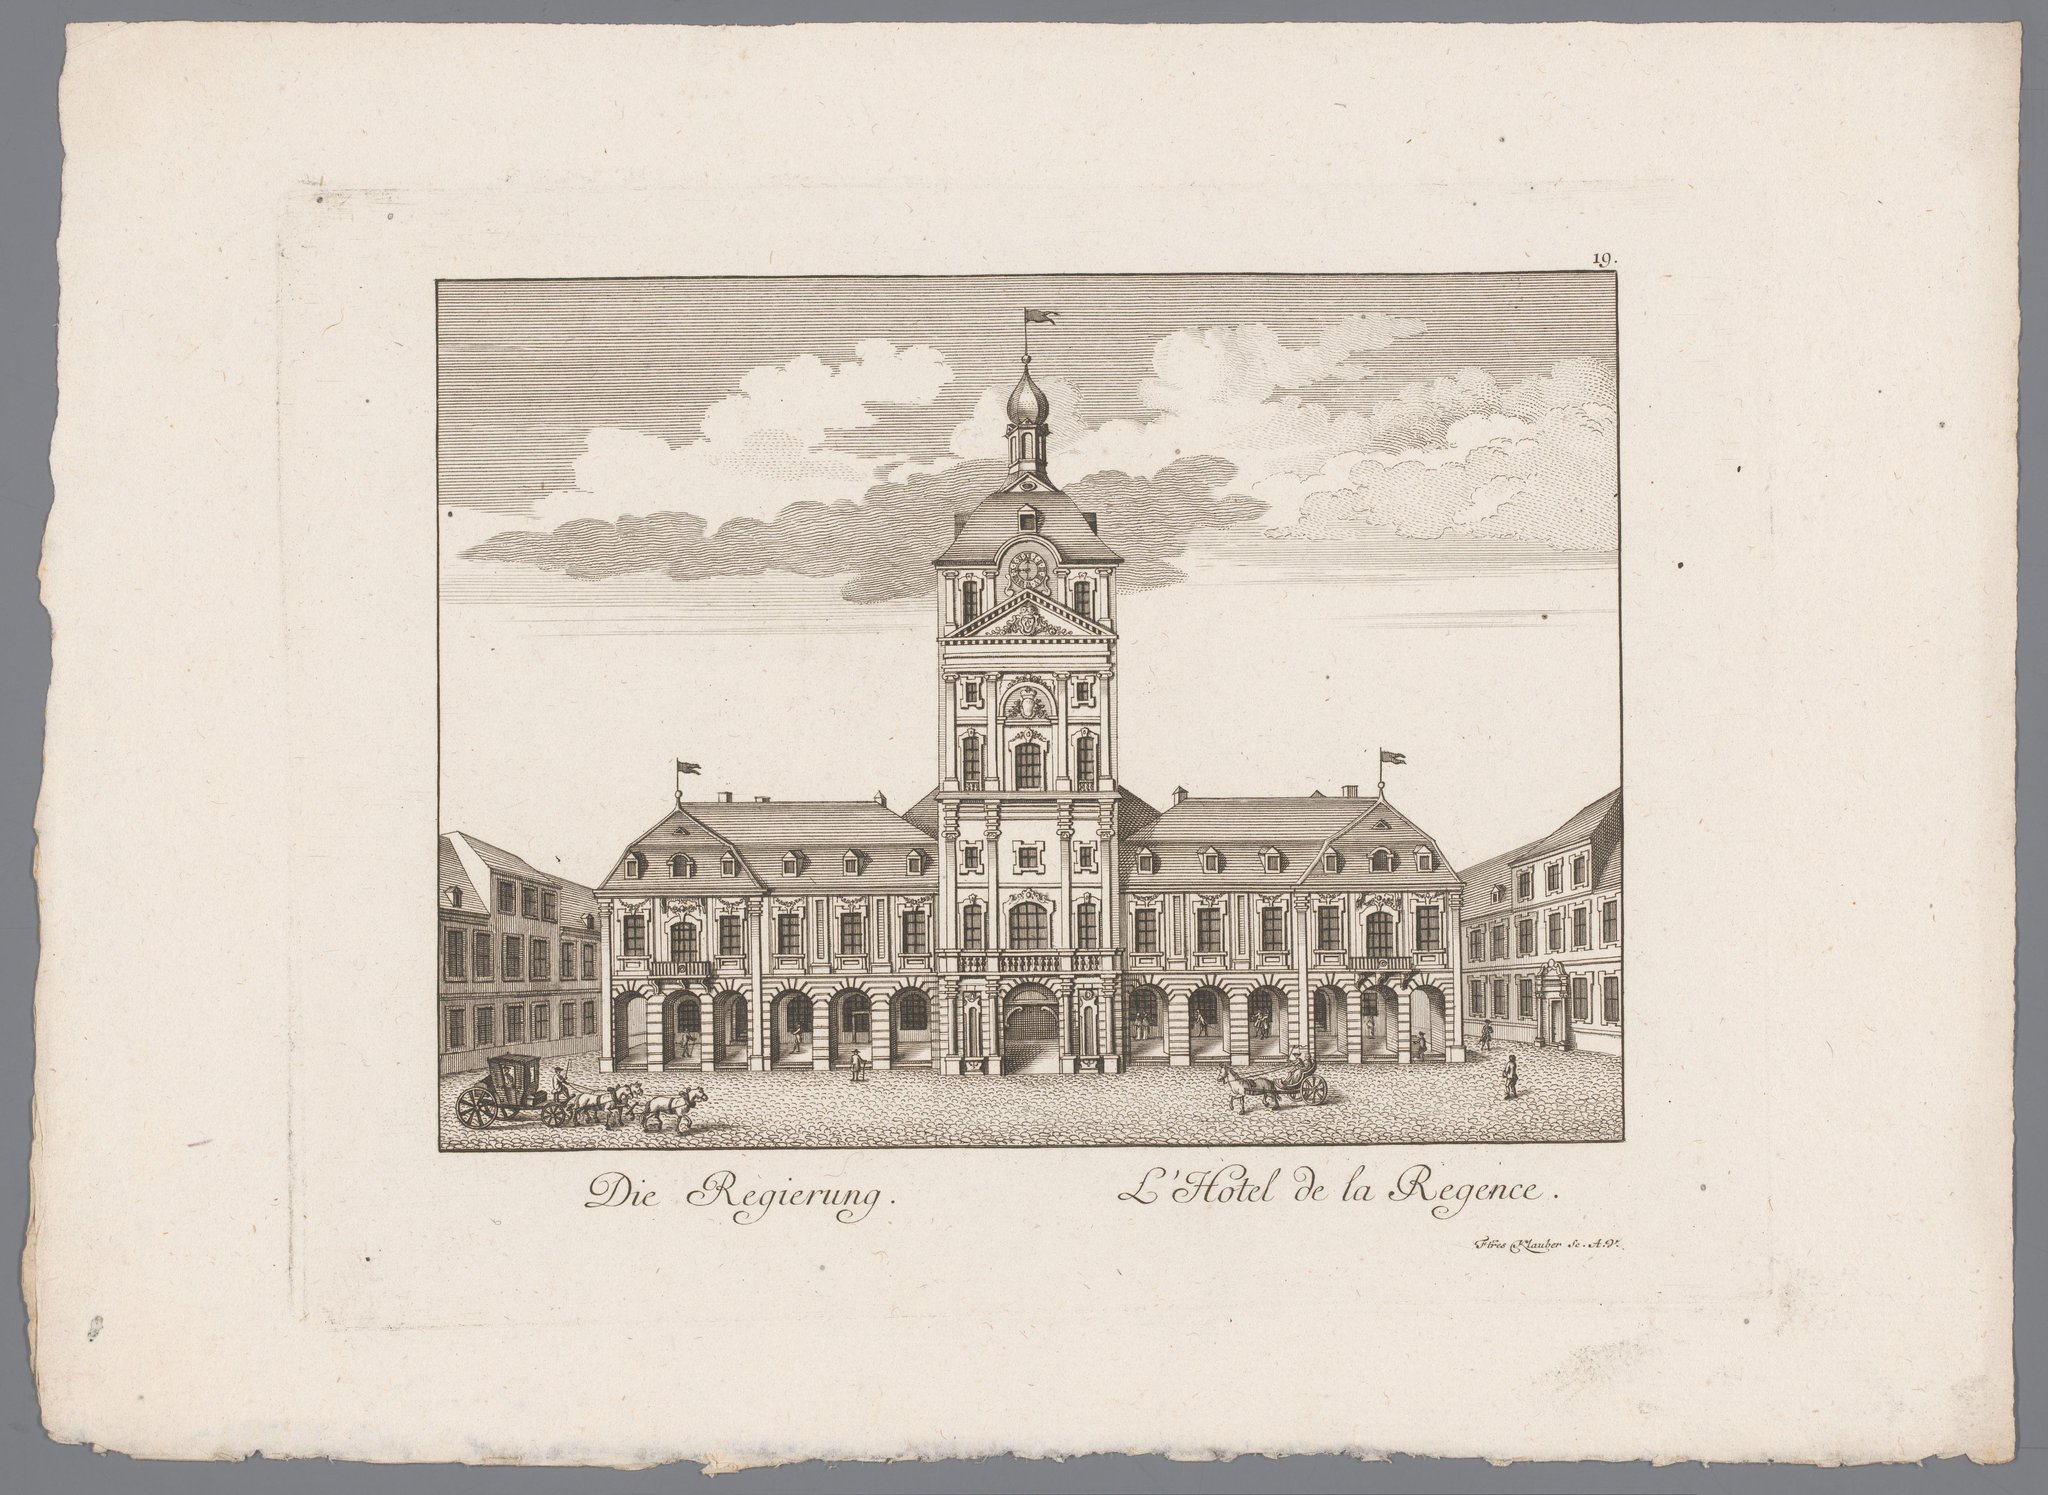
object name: print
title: Vues de Mannheim représentées sur vingt six planches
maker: christian friedrich schwan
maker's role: bookseller, publisher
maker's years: 1733-1815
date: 1782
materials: paper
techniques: engraving, etching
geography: mannheim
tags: townhall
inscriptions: collector's mark: Lugt 2228